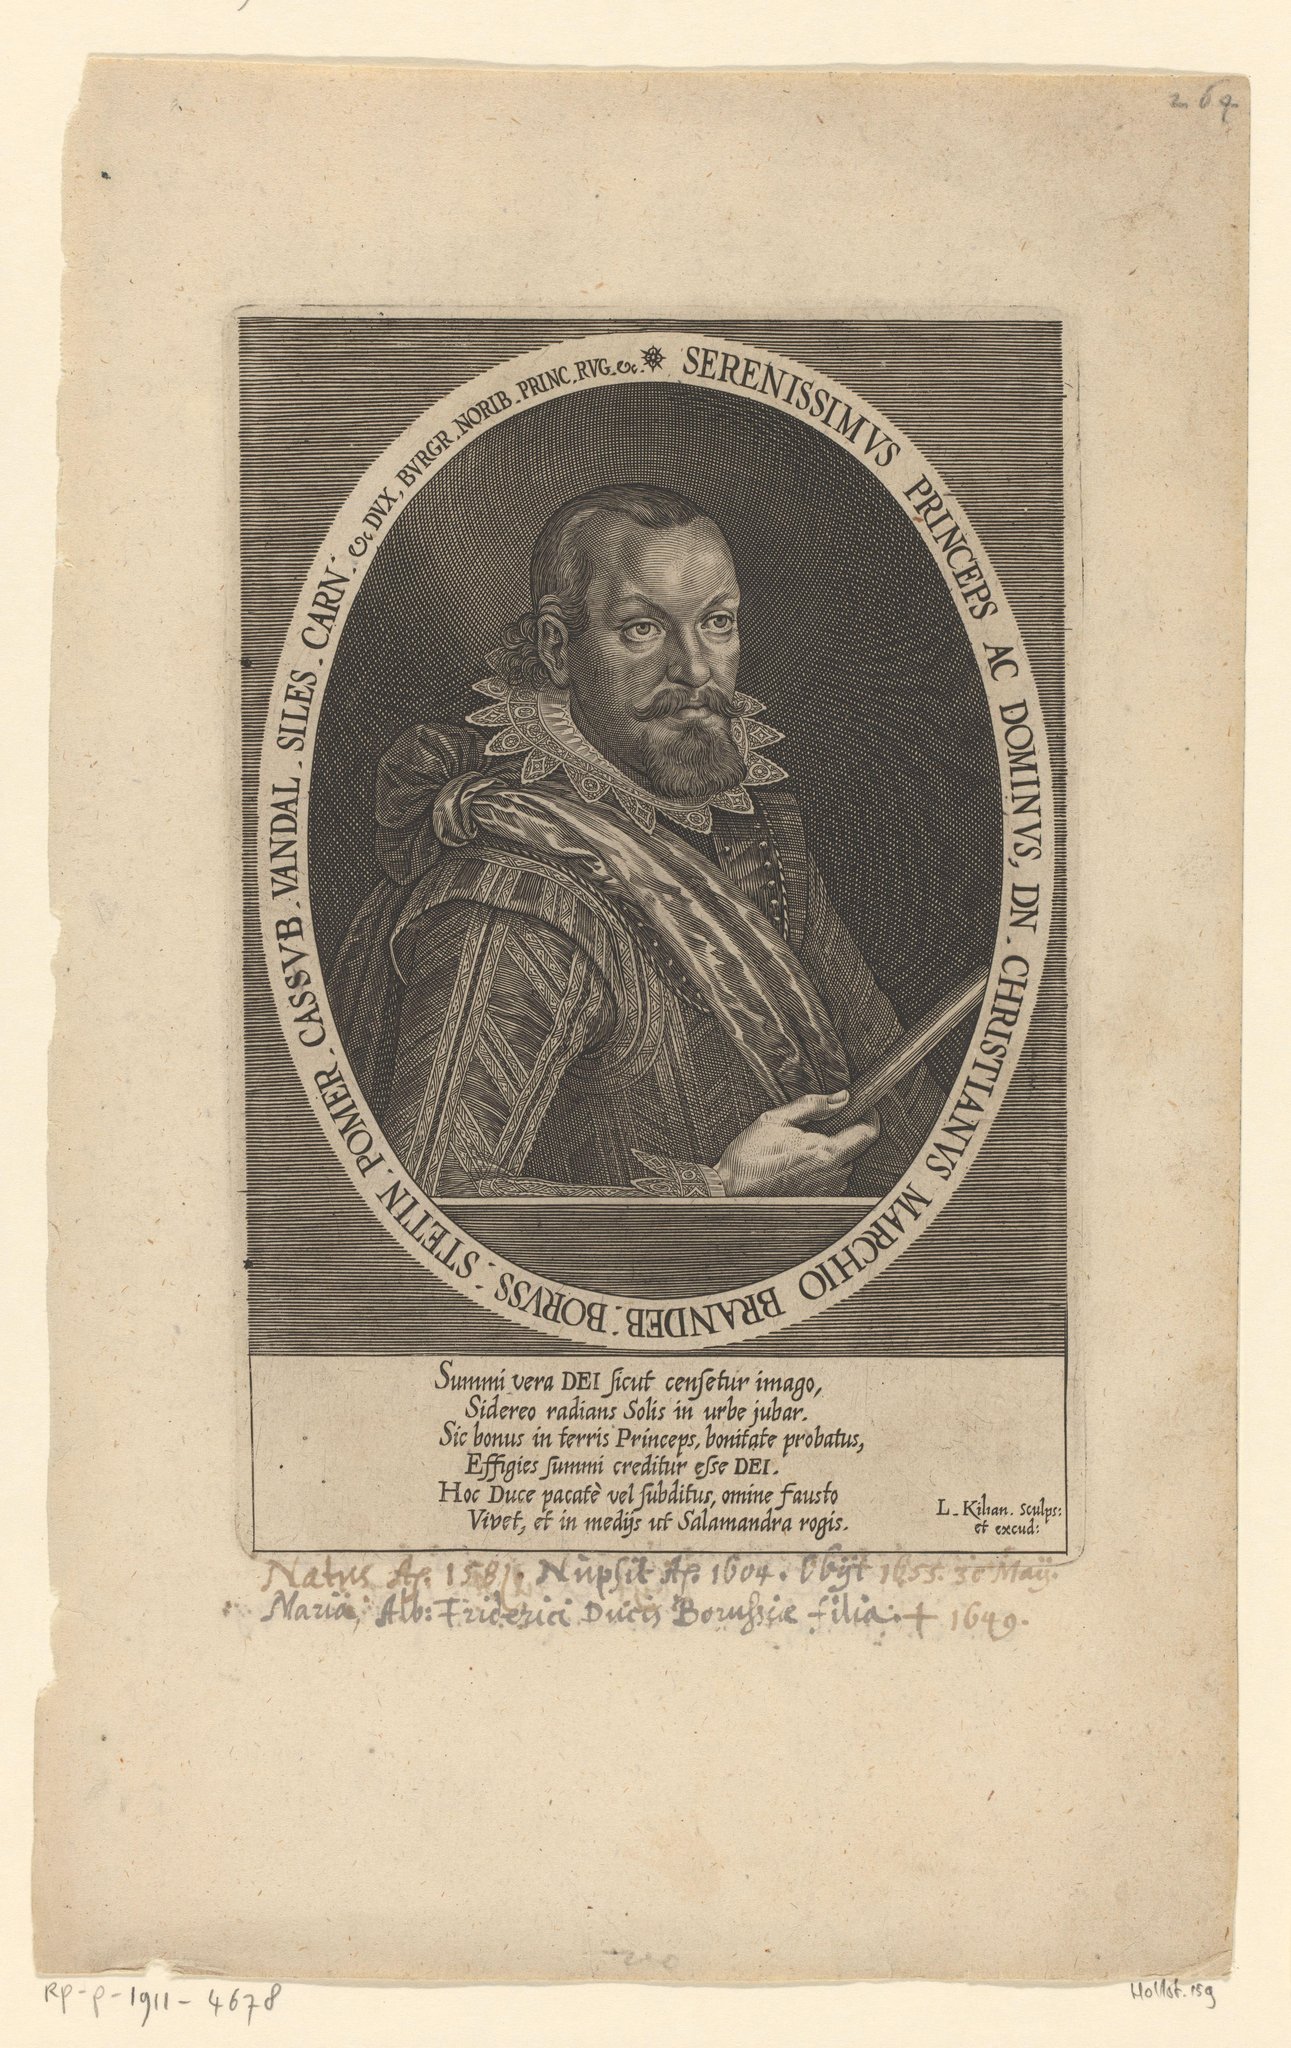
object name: print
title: Portret van Christian von Brandenburg-Kulmbach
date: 1603-1637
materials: paper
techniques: engraving, etching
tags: earl, historical persons, ruler, sovereign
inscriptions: collector's mark: Lugt 2228, annotation: ‘Natus Ae. (...) Filia 1649.’, annotation: ‘Eva (...) Wirtenberg.’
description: Tekst in het Latijn in de omlijsting en in de ondermarge.